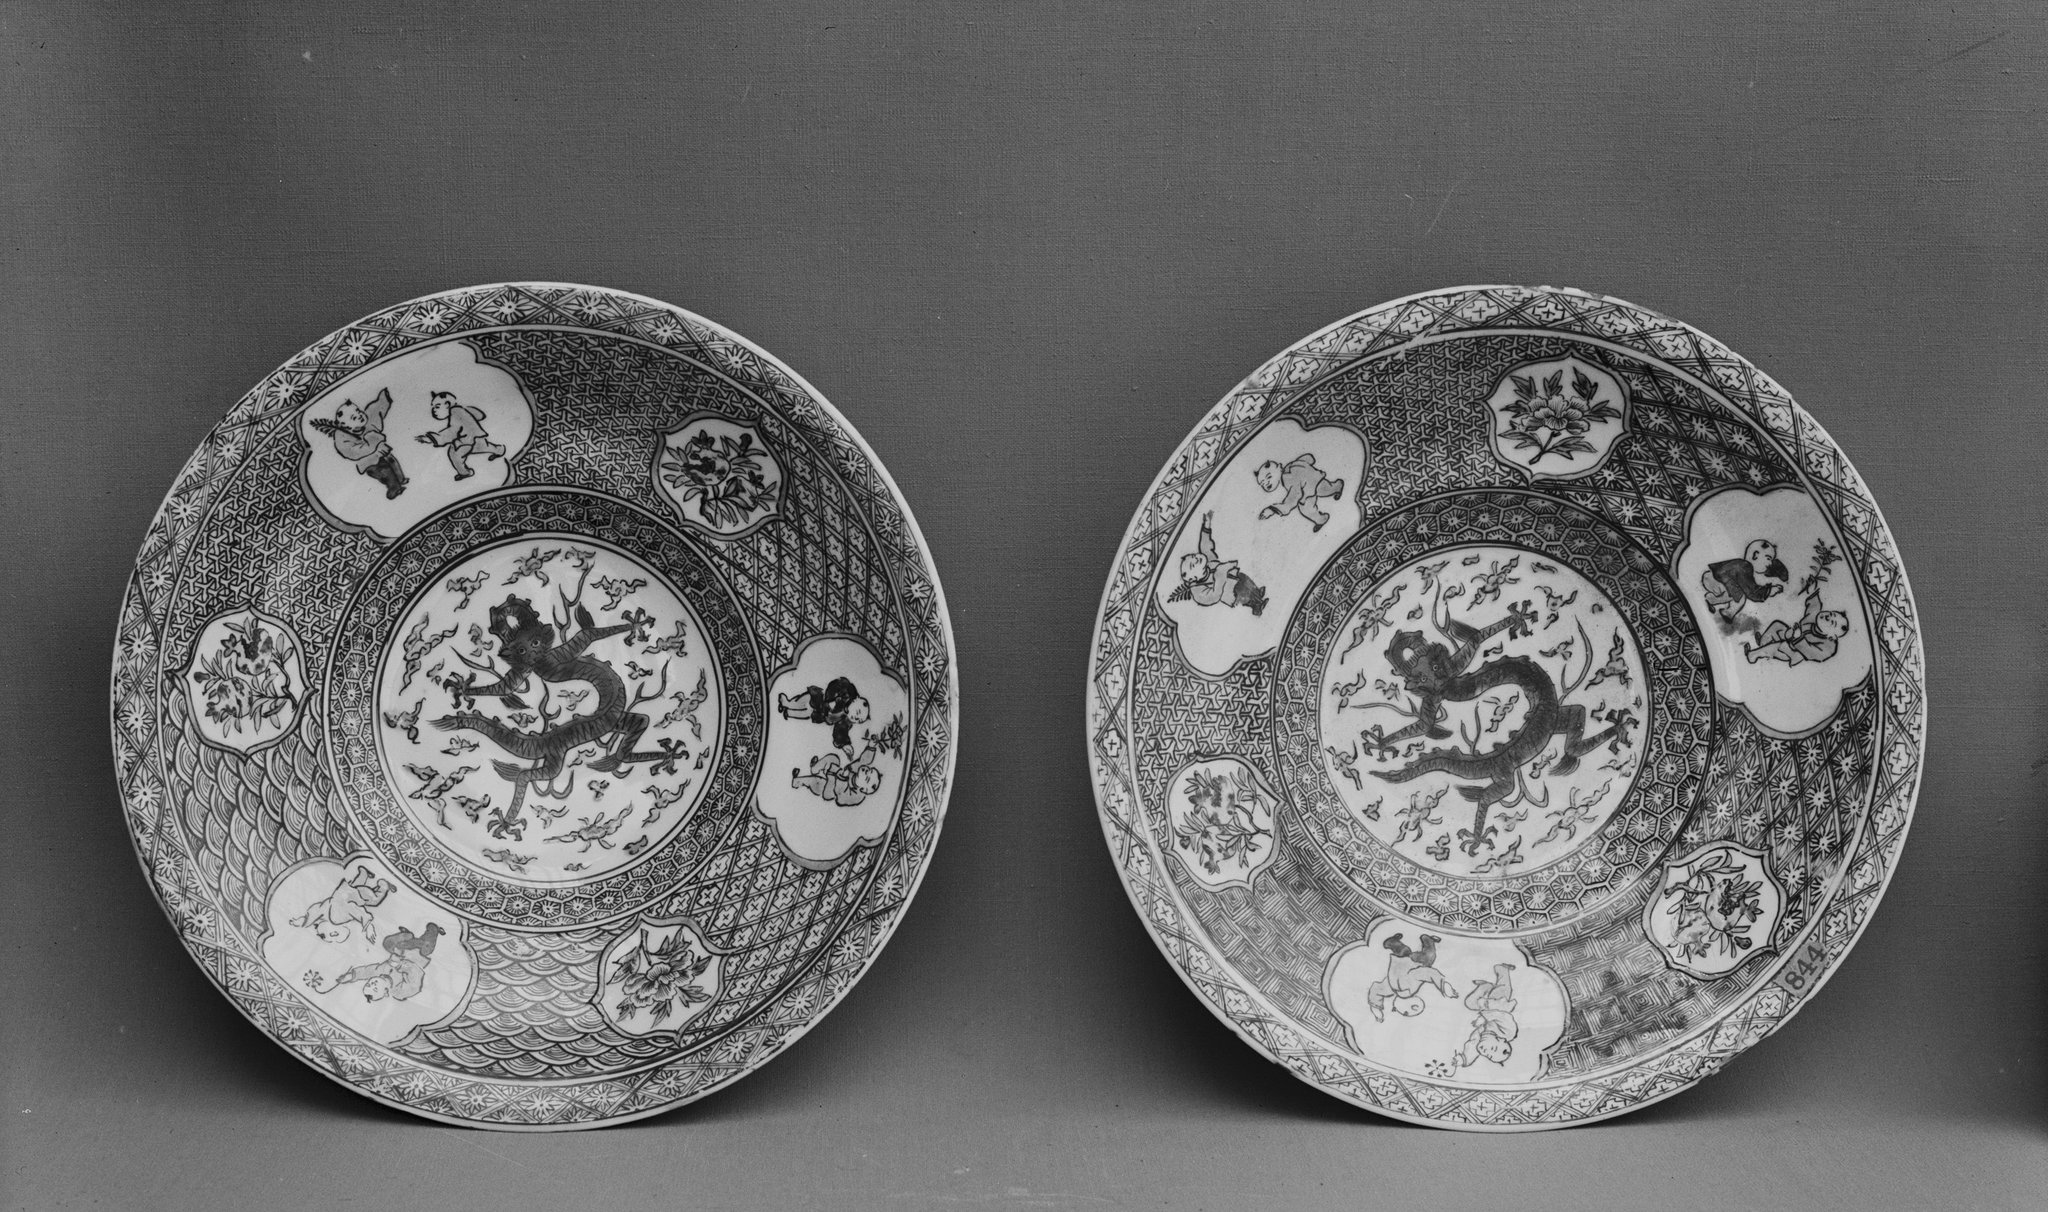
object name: dish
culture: japanese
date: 1801-1900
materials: enamel, iron, porcelain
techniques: polychrome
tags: children